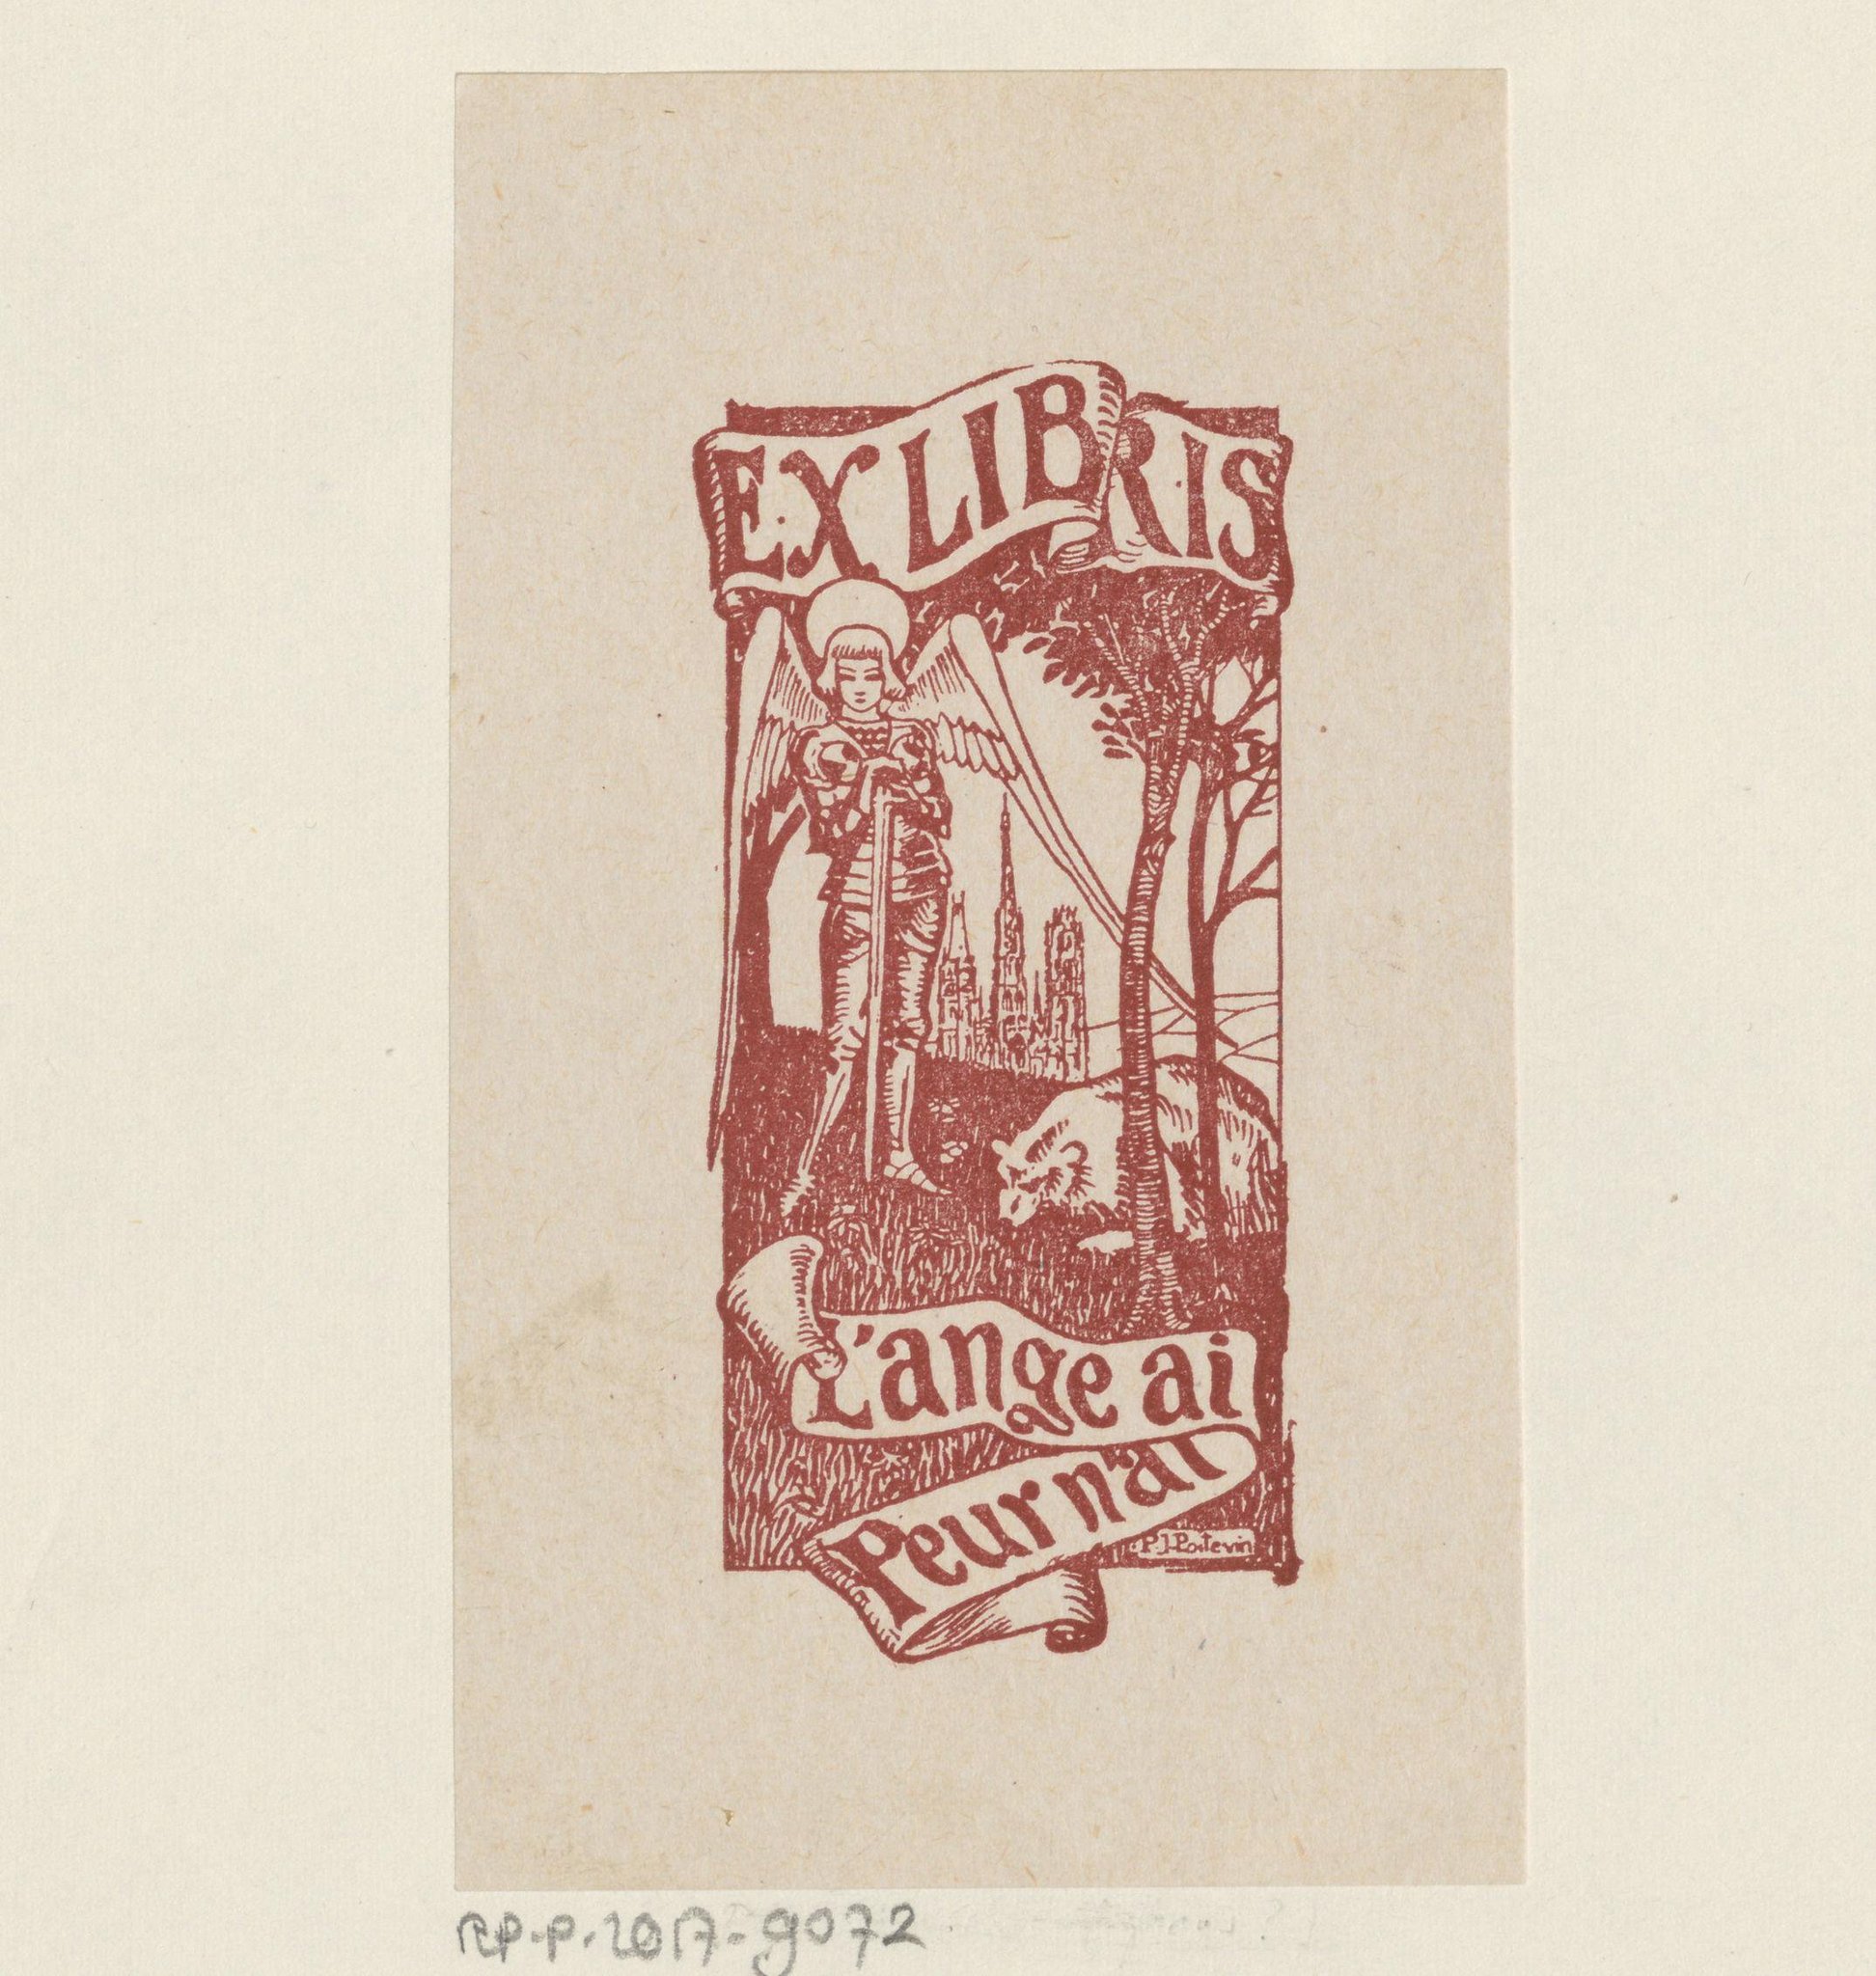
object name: bookplate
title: Ex libris van onbekend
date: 1899-1933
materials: paper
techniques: printing block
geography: france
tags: trees, beasts of prey, predatory animals: bear, angels